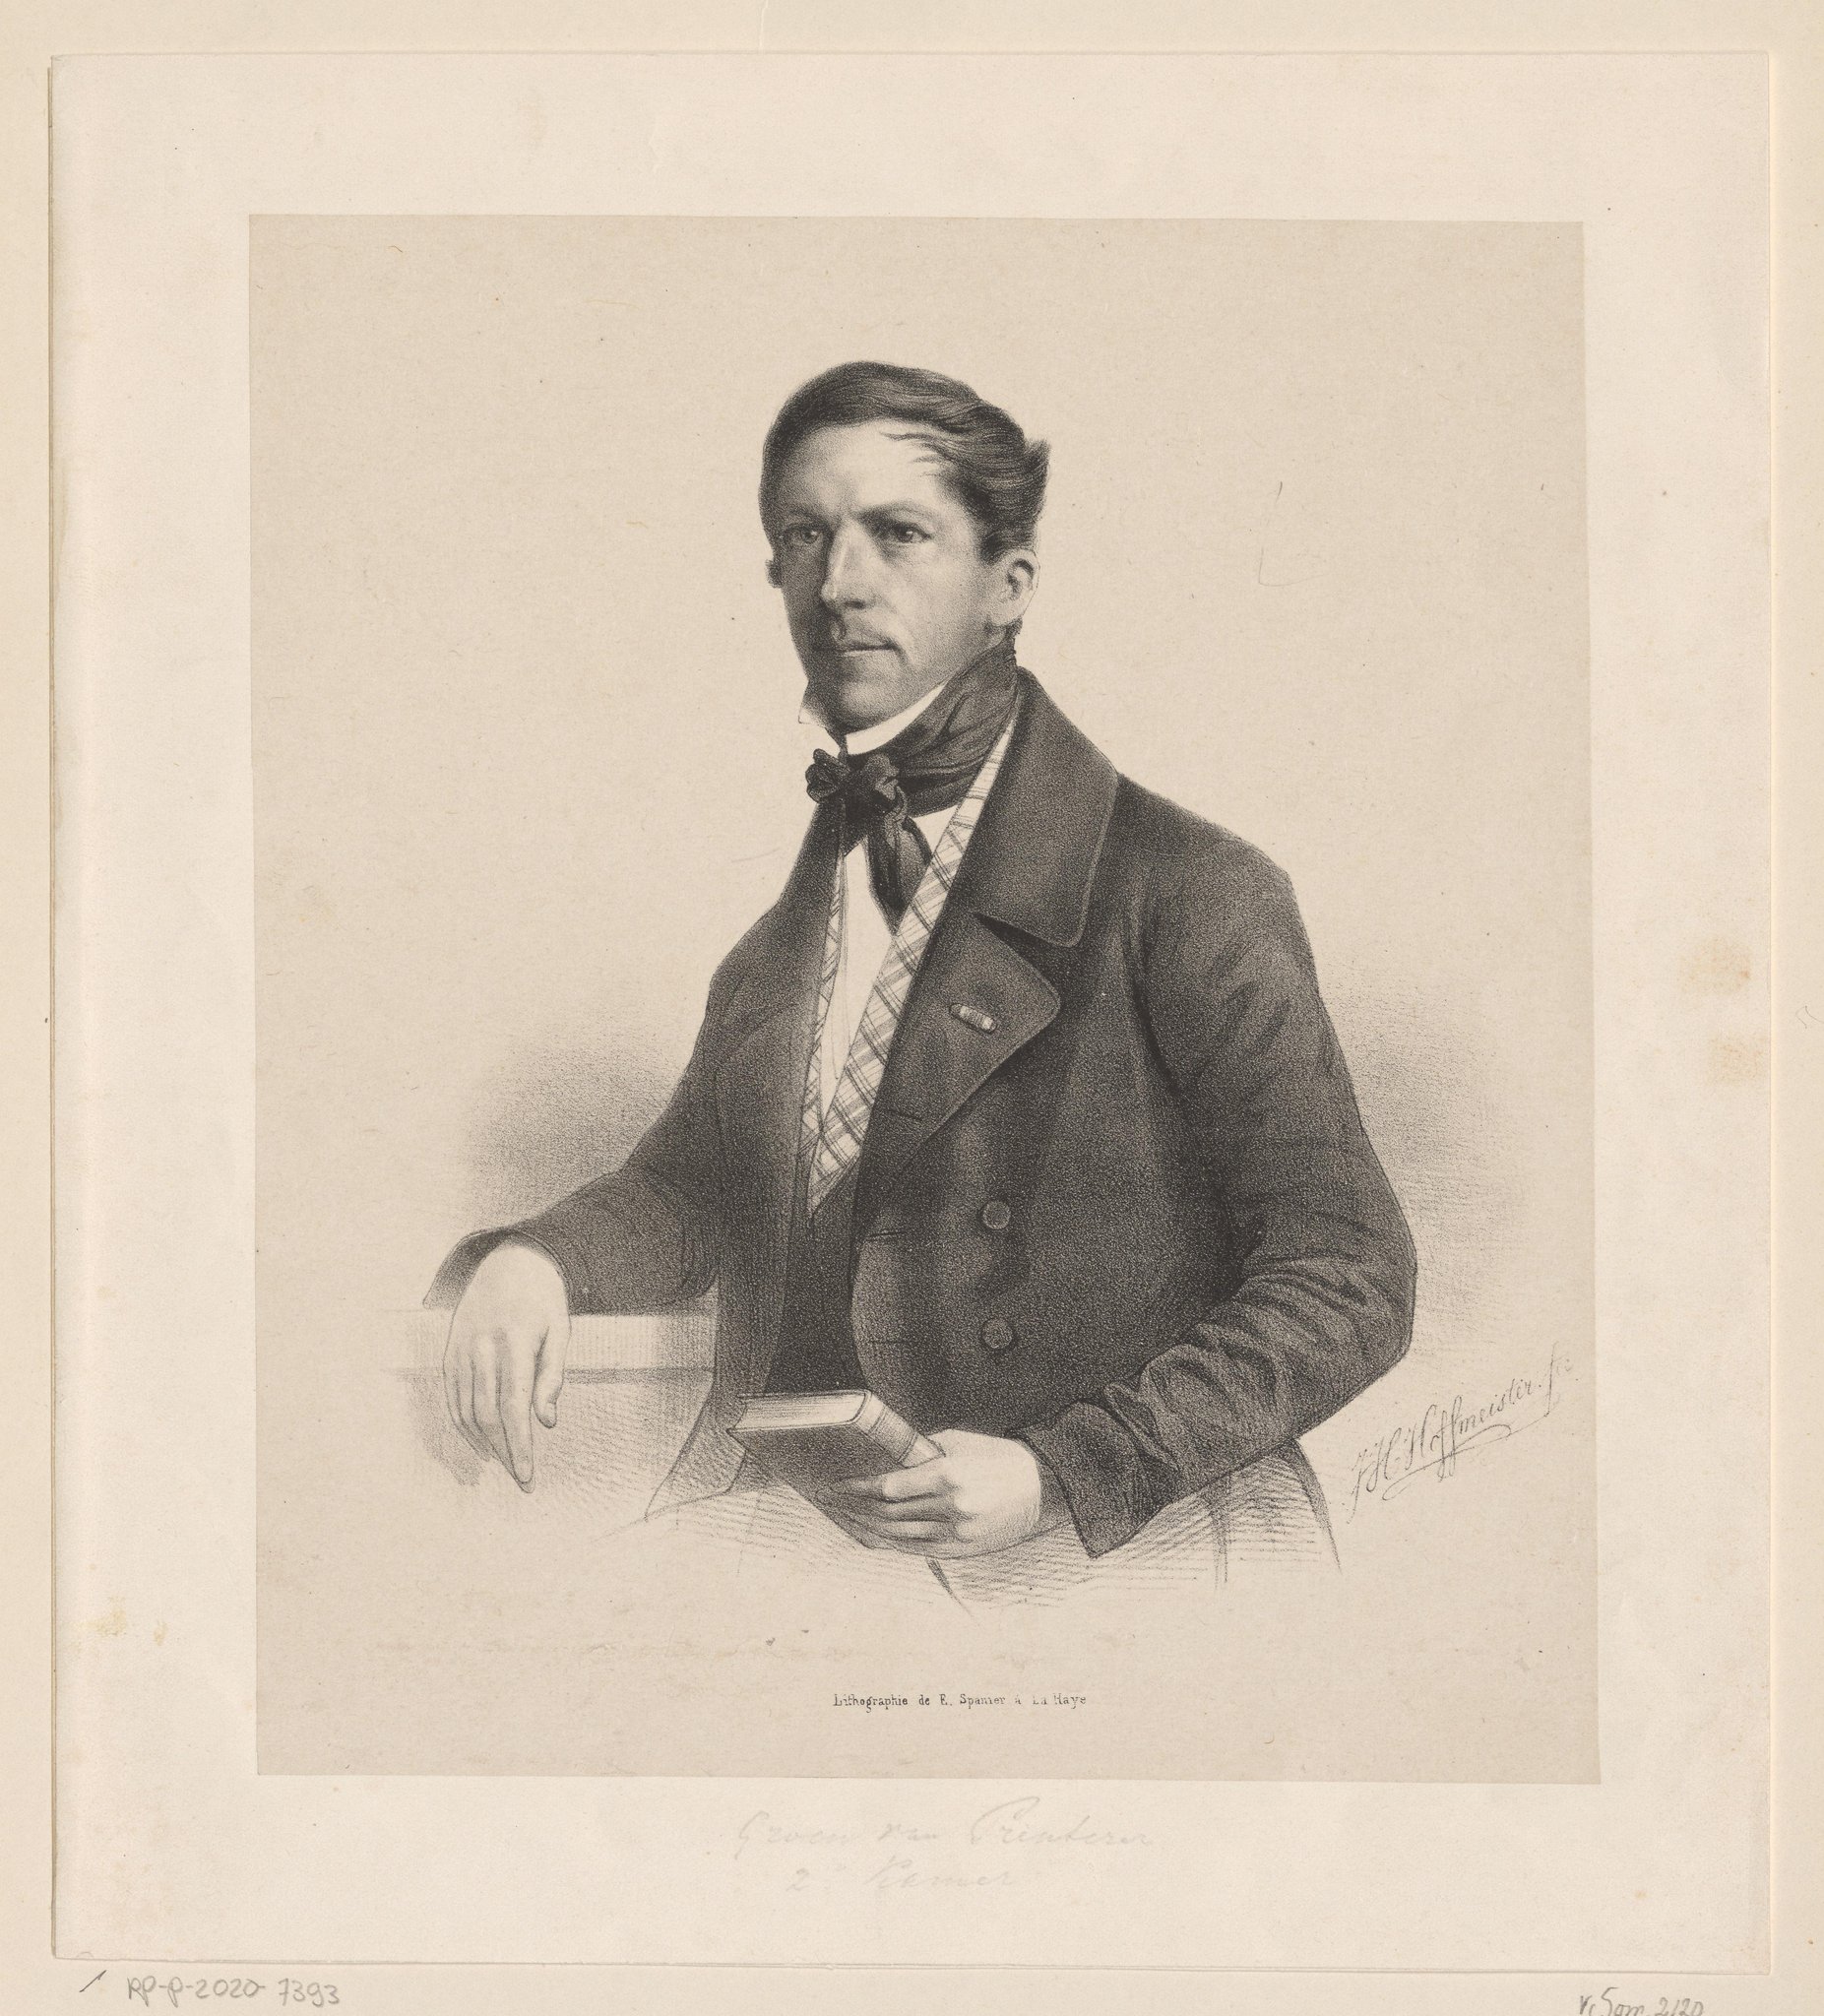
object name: print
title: Portret van Guillaume Groen van Prinsterer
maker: johan hendrik hoffmeister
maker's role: print maker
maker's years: 1823-1904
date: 1843-1863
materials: paper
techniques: lithograph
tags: guillaume groen van prinsterer, historical persons, portrait of a writer